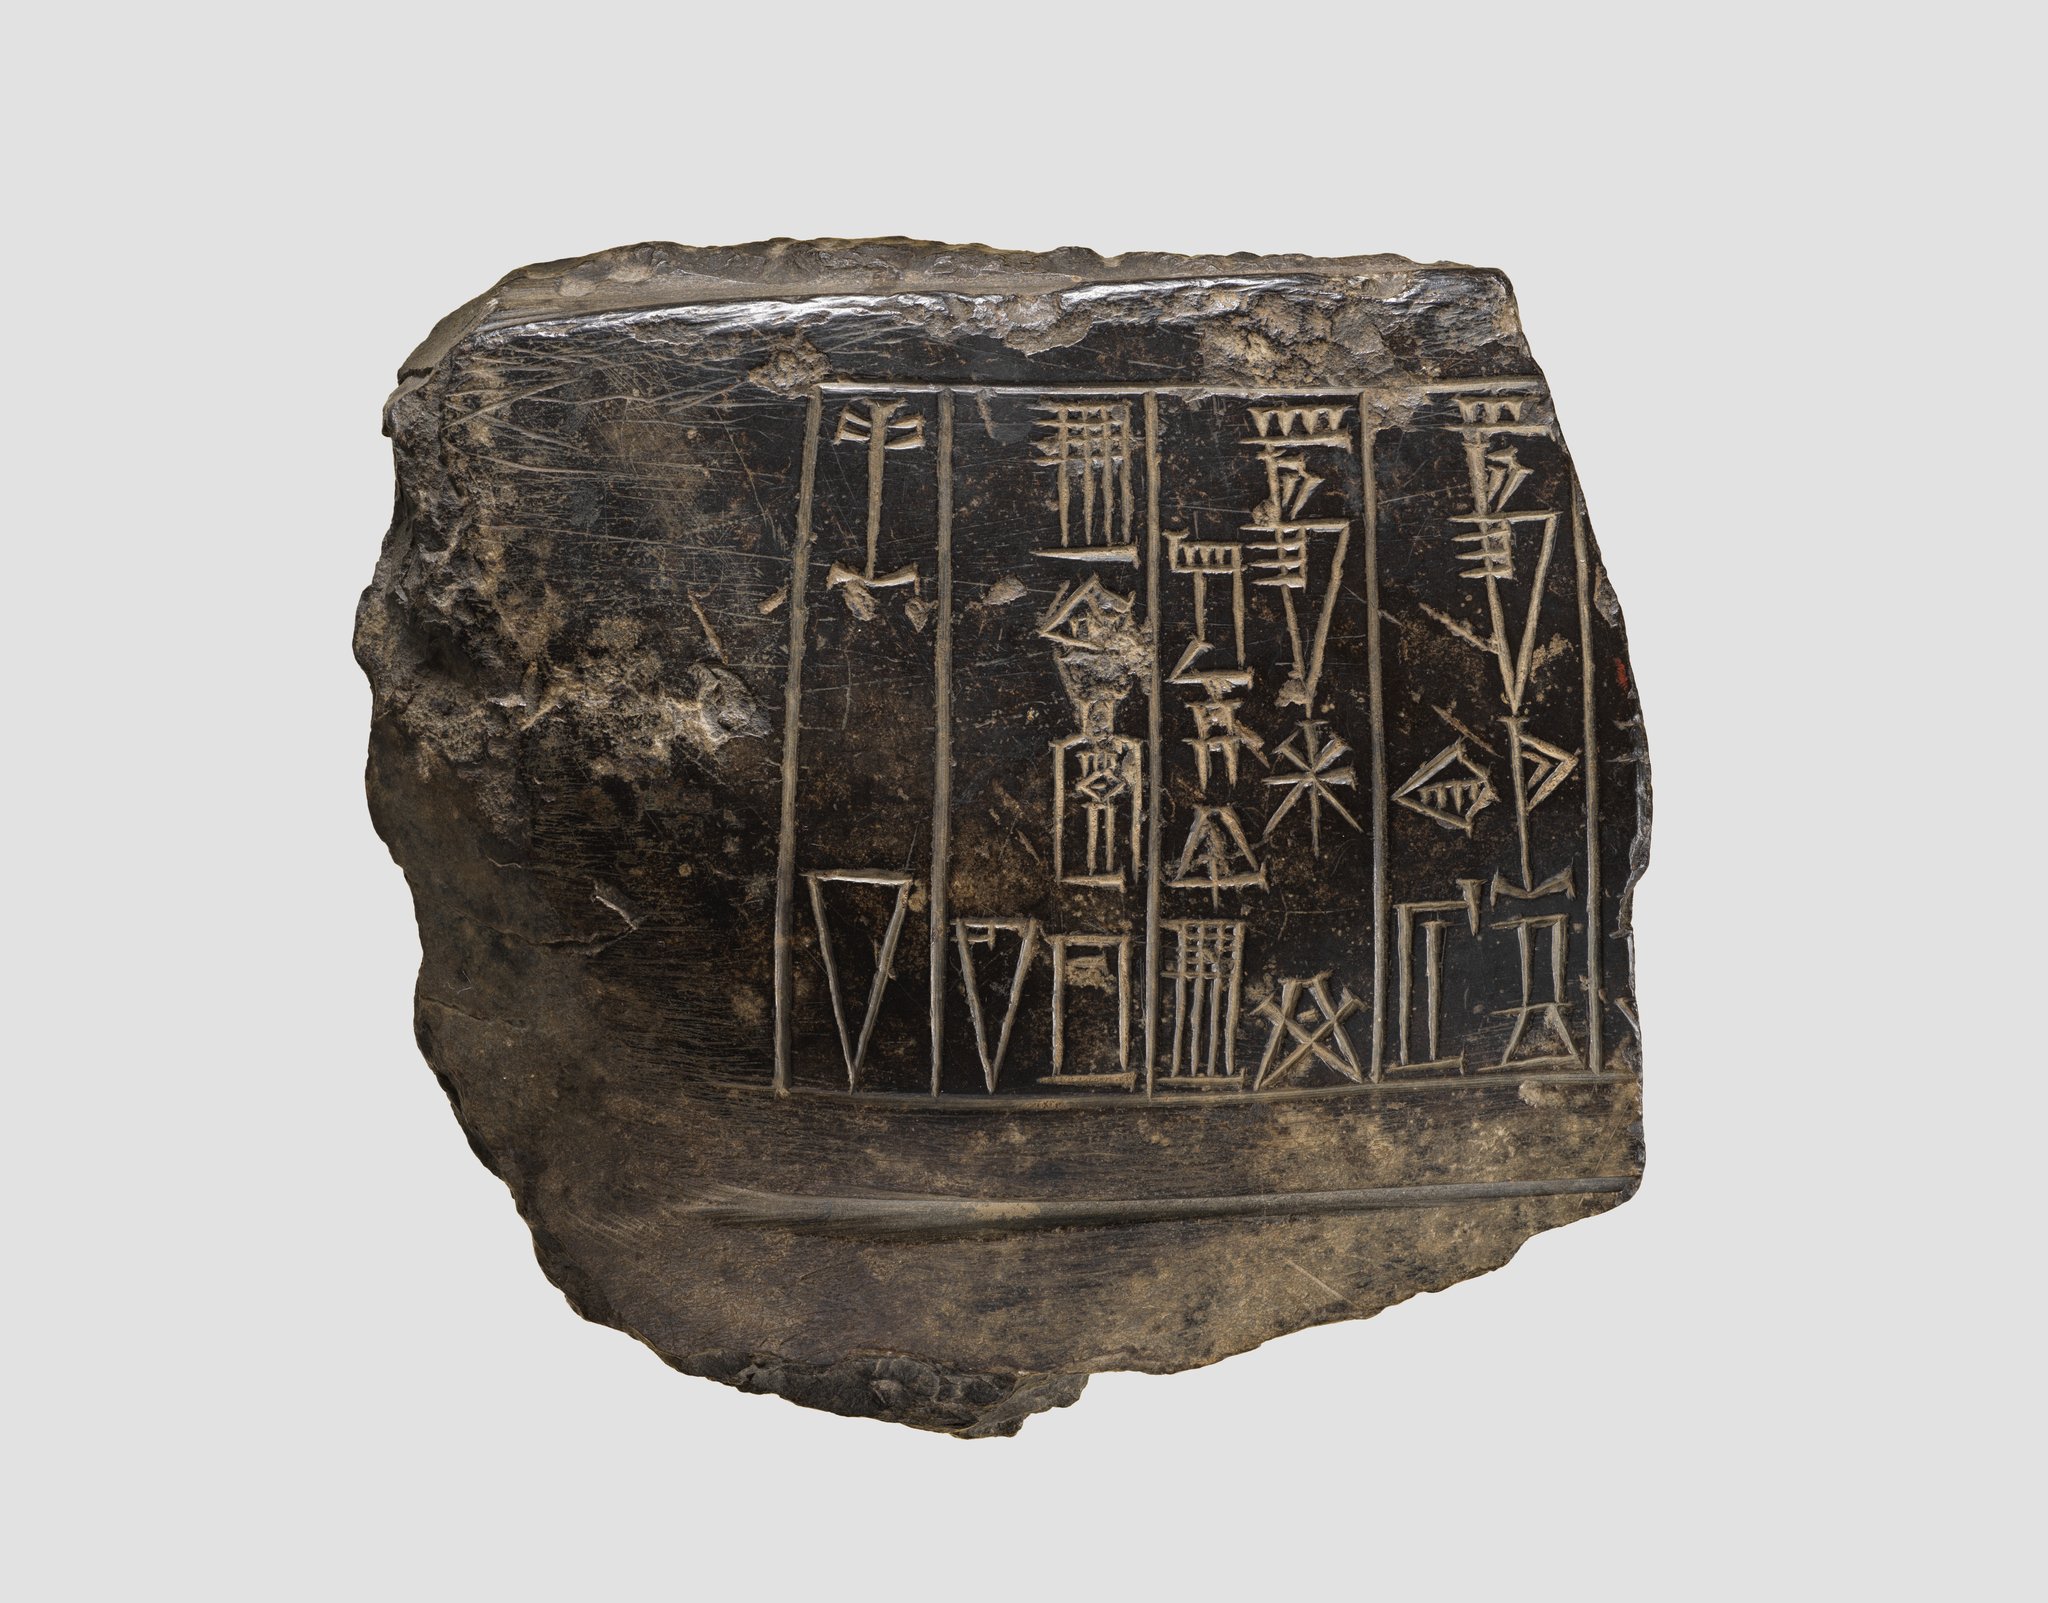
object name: sculpture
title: Statue fragment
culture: neo-sumerian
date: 2112-2004 BCE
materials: marble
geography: mesopotamia